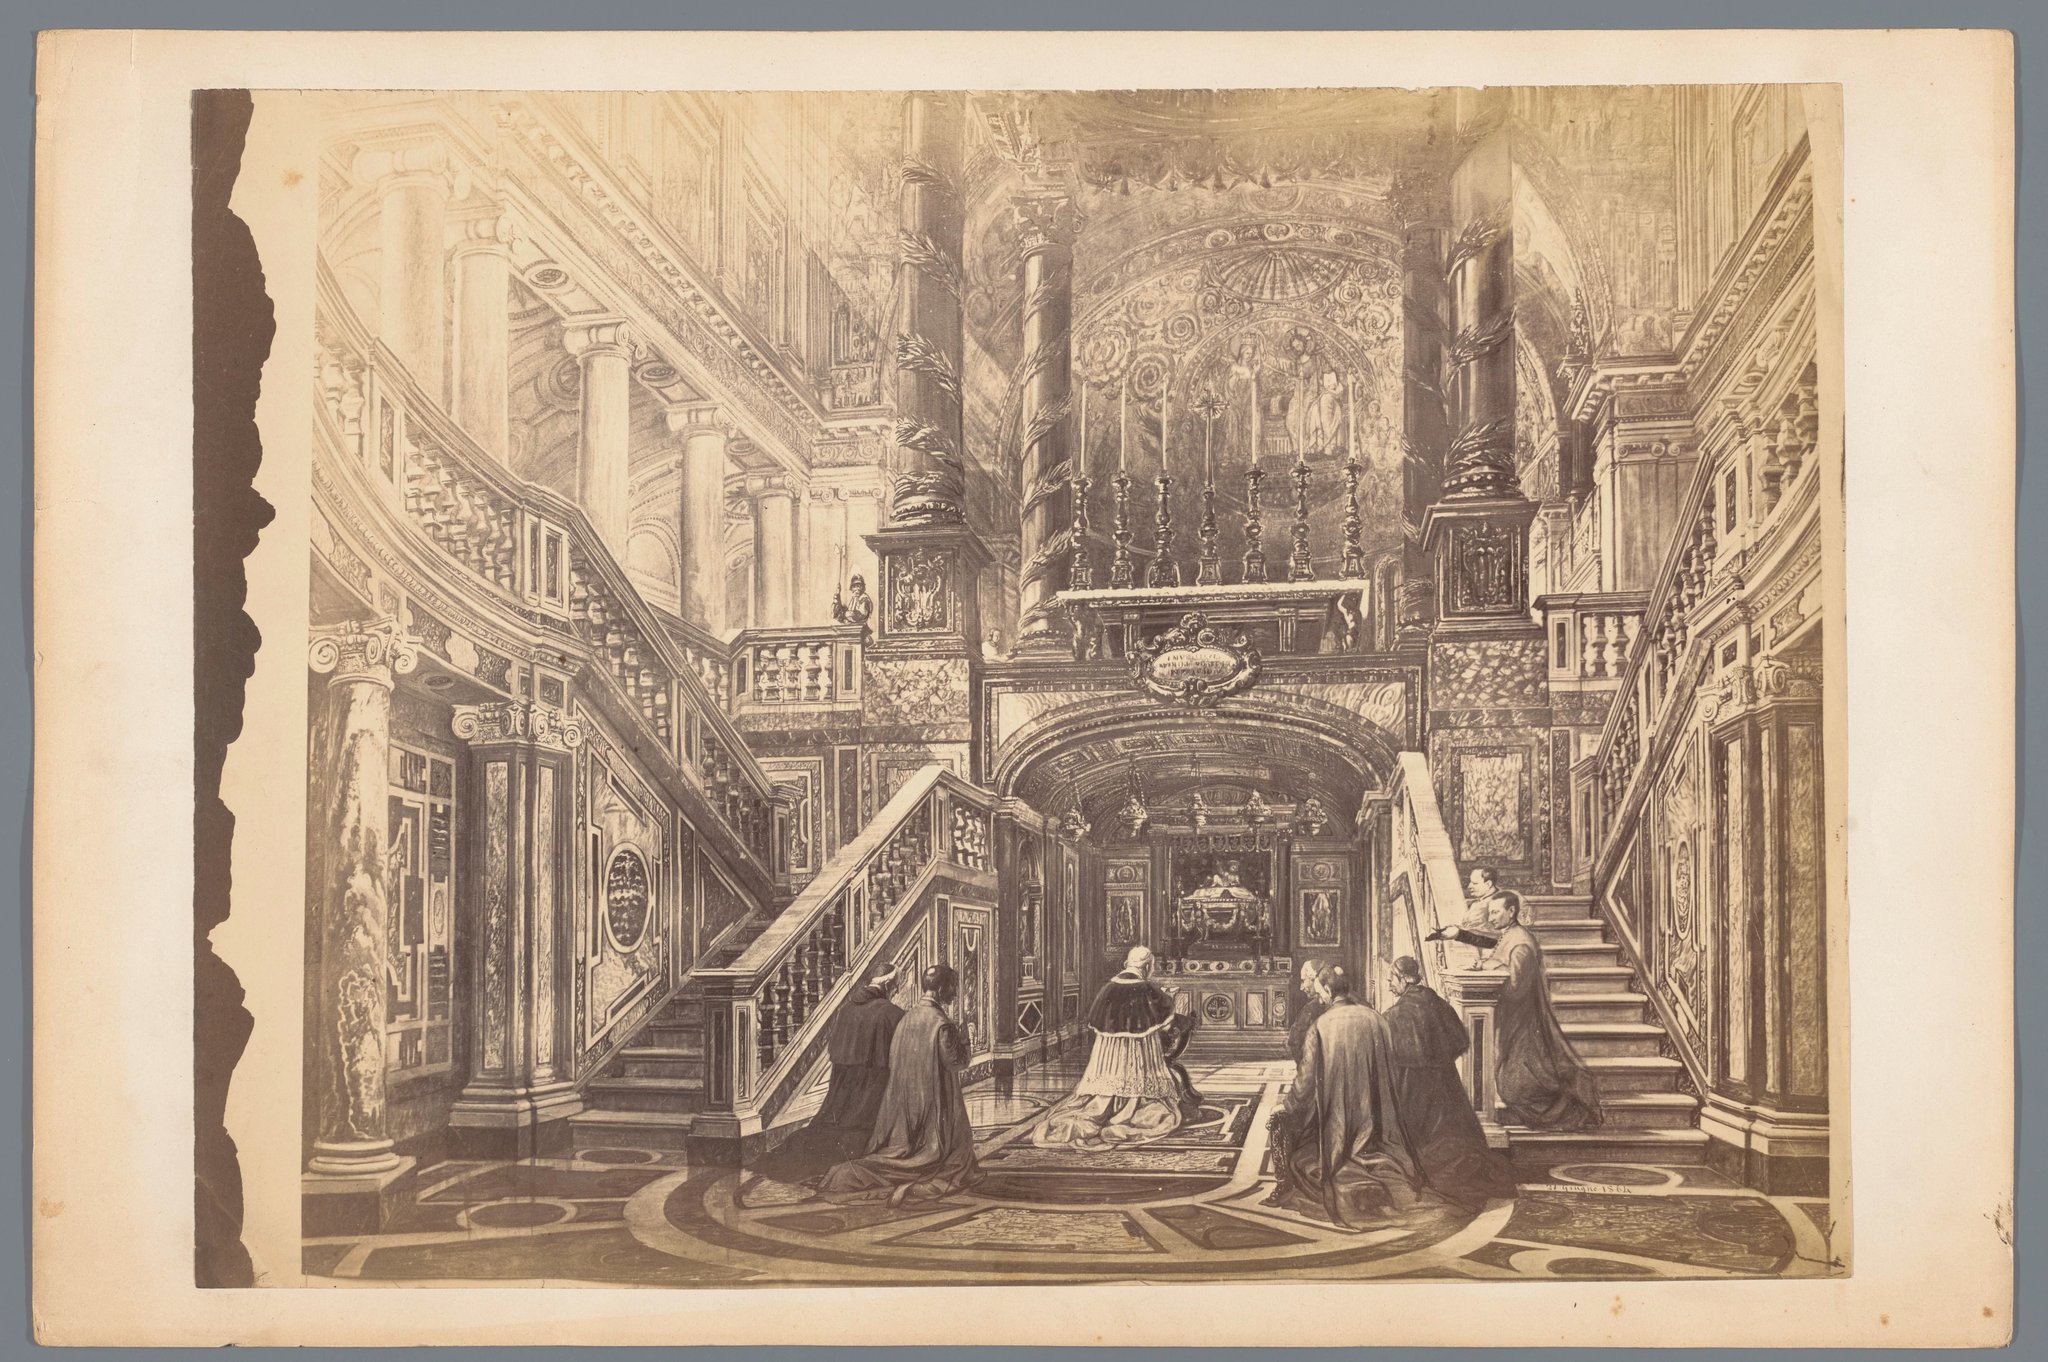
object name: photograph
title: Fotoreproductie van een schilderij, voorstellende de paus en geestelijken in gebed in een kerk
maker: Anonymous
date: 1875-1900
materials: cardboard, photographic support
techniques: albumen print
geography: europe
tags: (public) prayer, interior of church, pope, europe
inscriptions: collector's mark: Lugt 3937